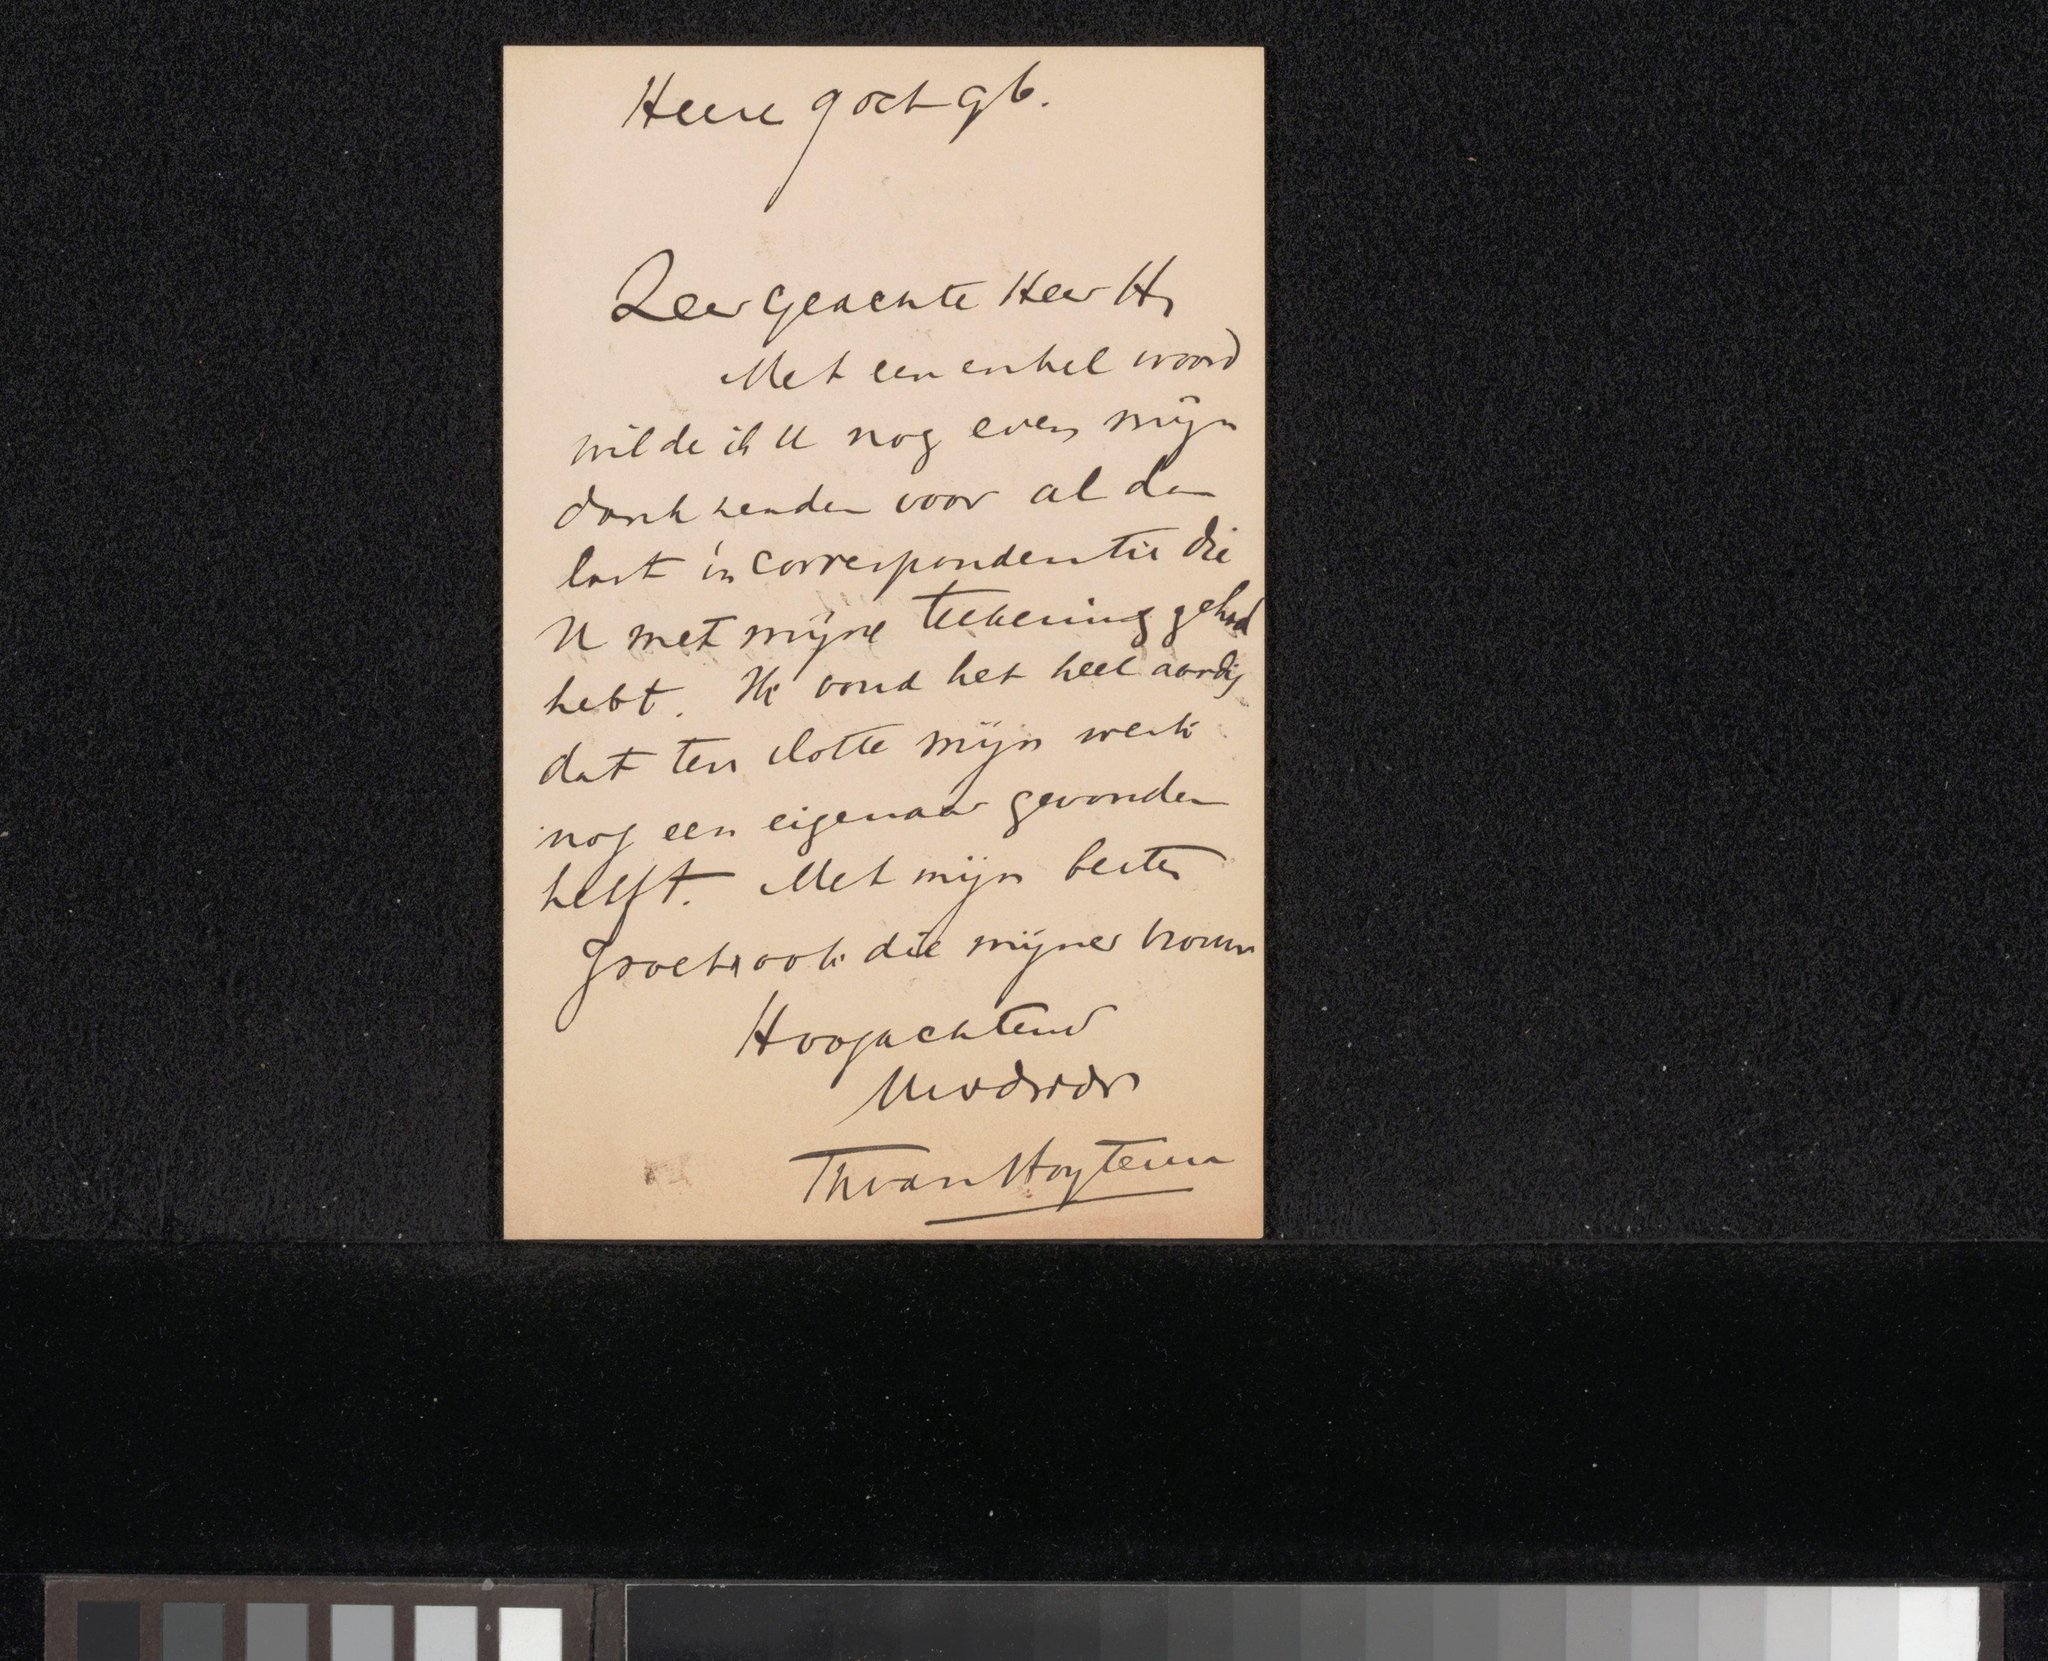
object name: letter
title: Brief aan anoniem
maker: theo van hoytema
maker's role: draughtsman, painter, print maker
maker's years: 1863-1917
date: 1896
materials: ink, paper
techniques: pen, writing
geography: heere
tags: drawing